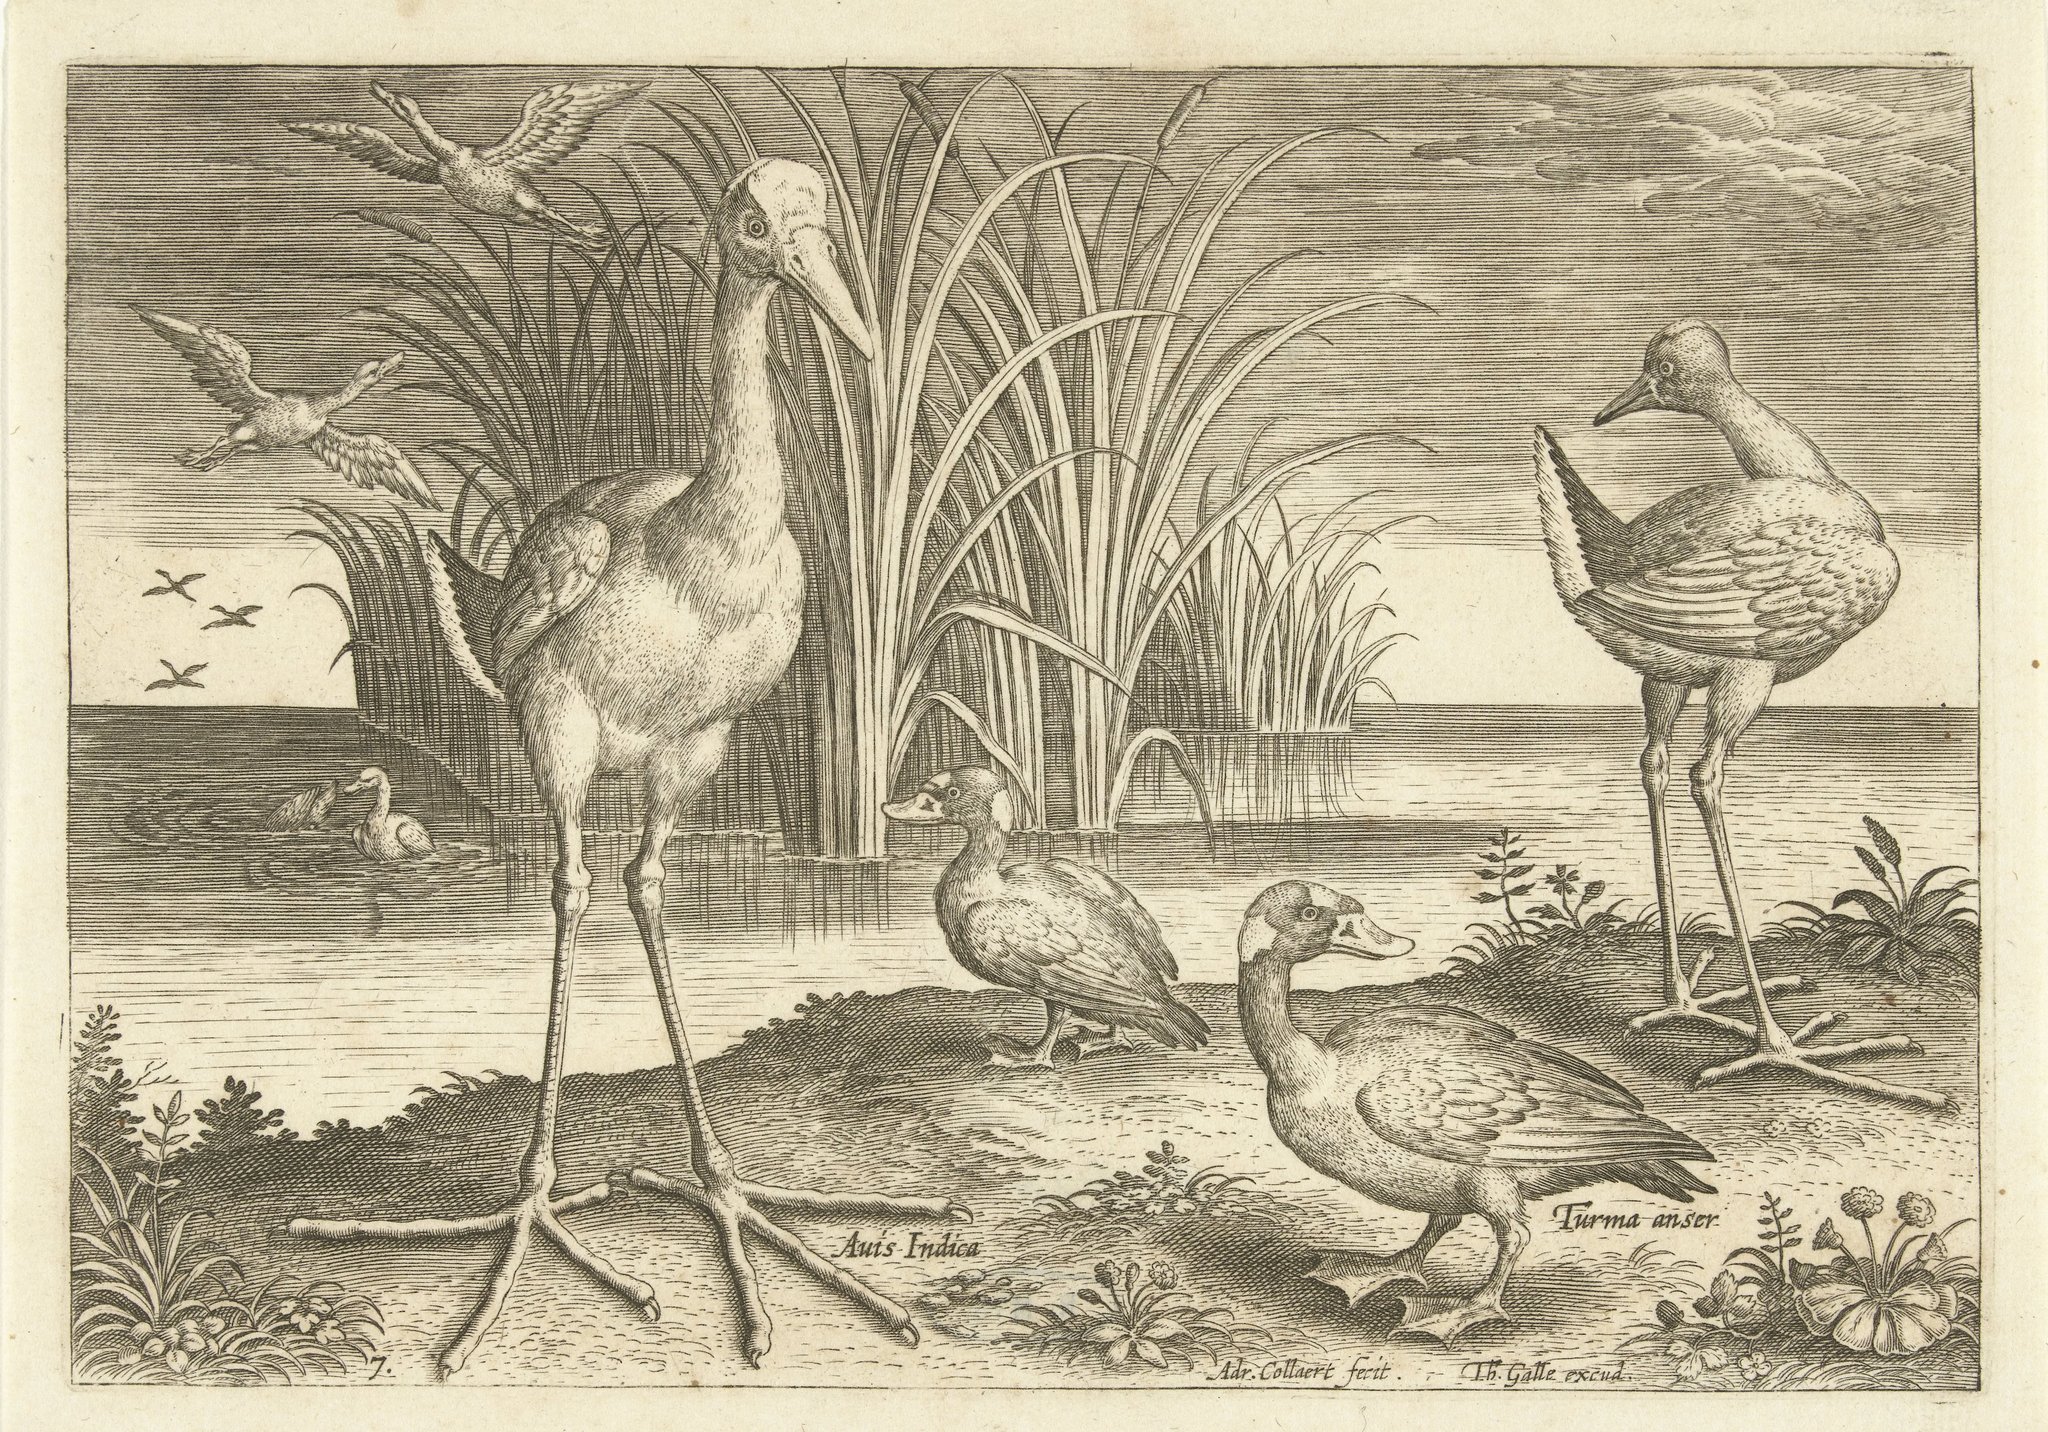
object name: print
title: Avivm vivae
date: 1598-1618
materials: paper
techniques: engraving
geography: antwerp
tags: river bank, shore-birds and wading-birds: giant snipe, water-birds: duck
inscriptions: collector's mark: Lugt 2228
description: Twee reuzensnips en twee brilzee-eenden aan de oever van een meer. Op de achtergrond enkele eenden in het riet. De prent maakt deel uit van een serie met vogels als onderwerp.